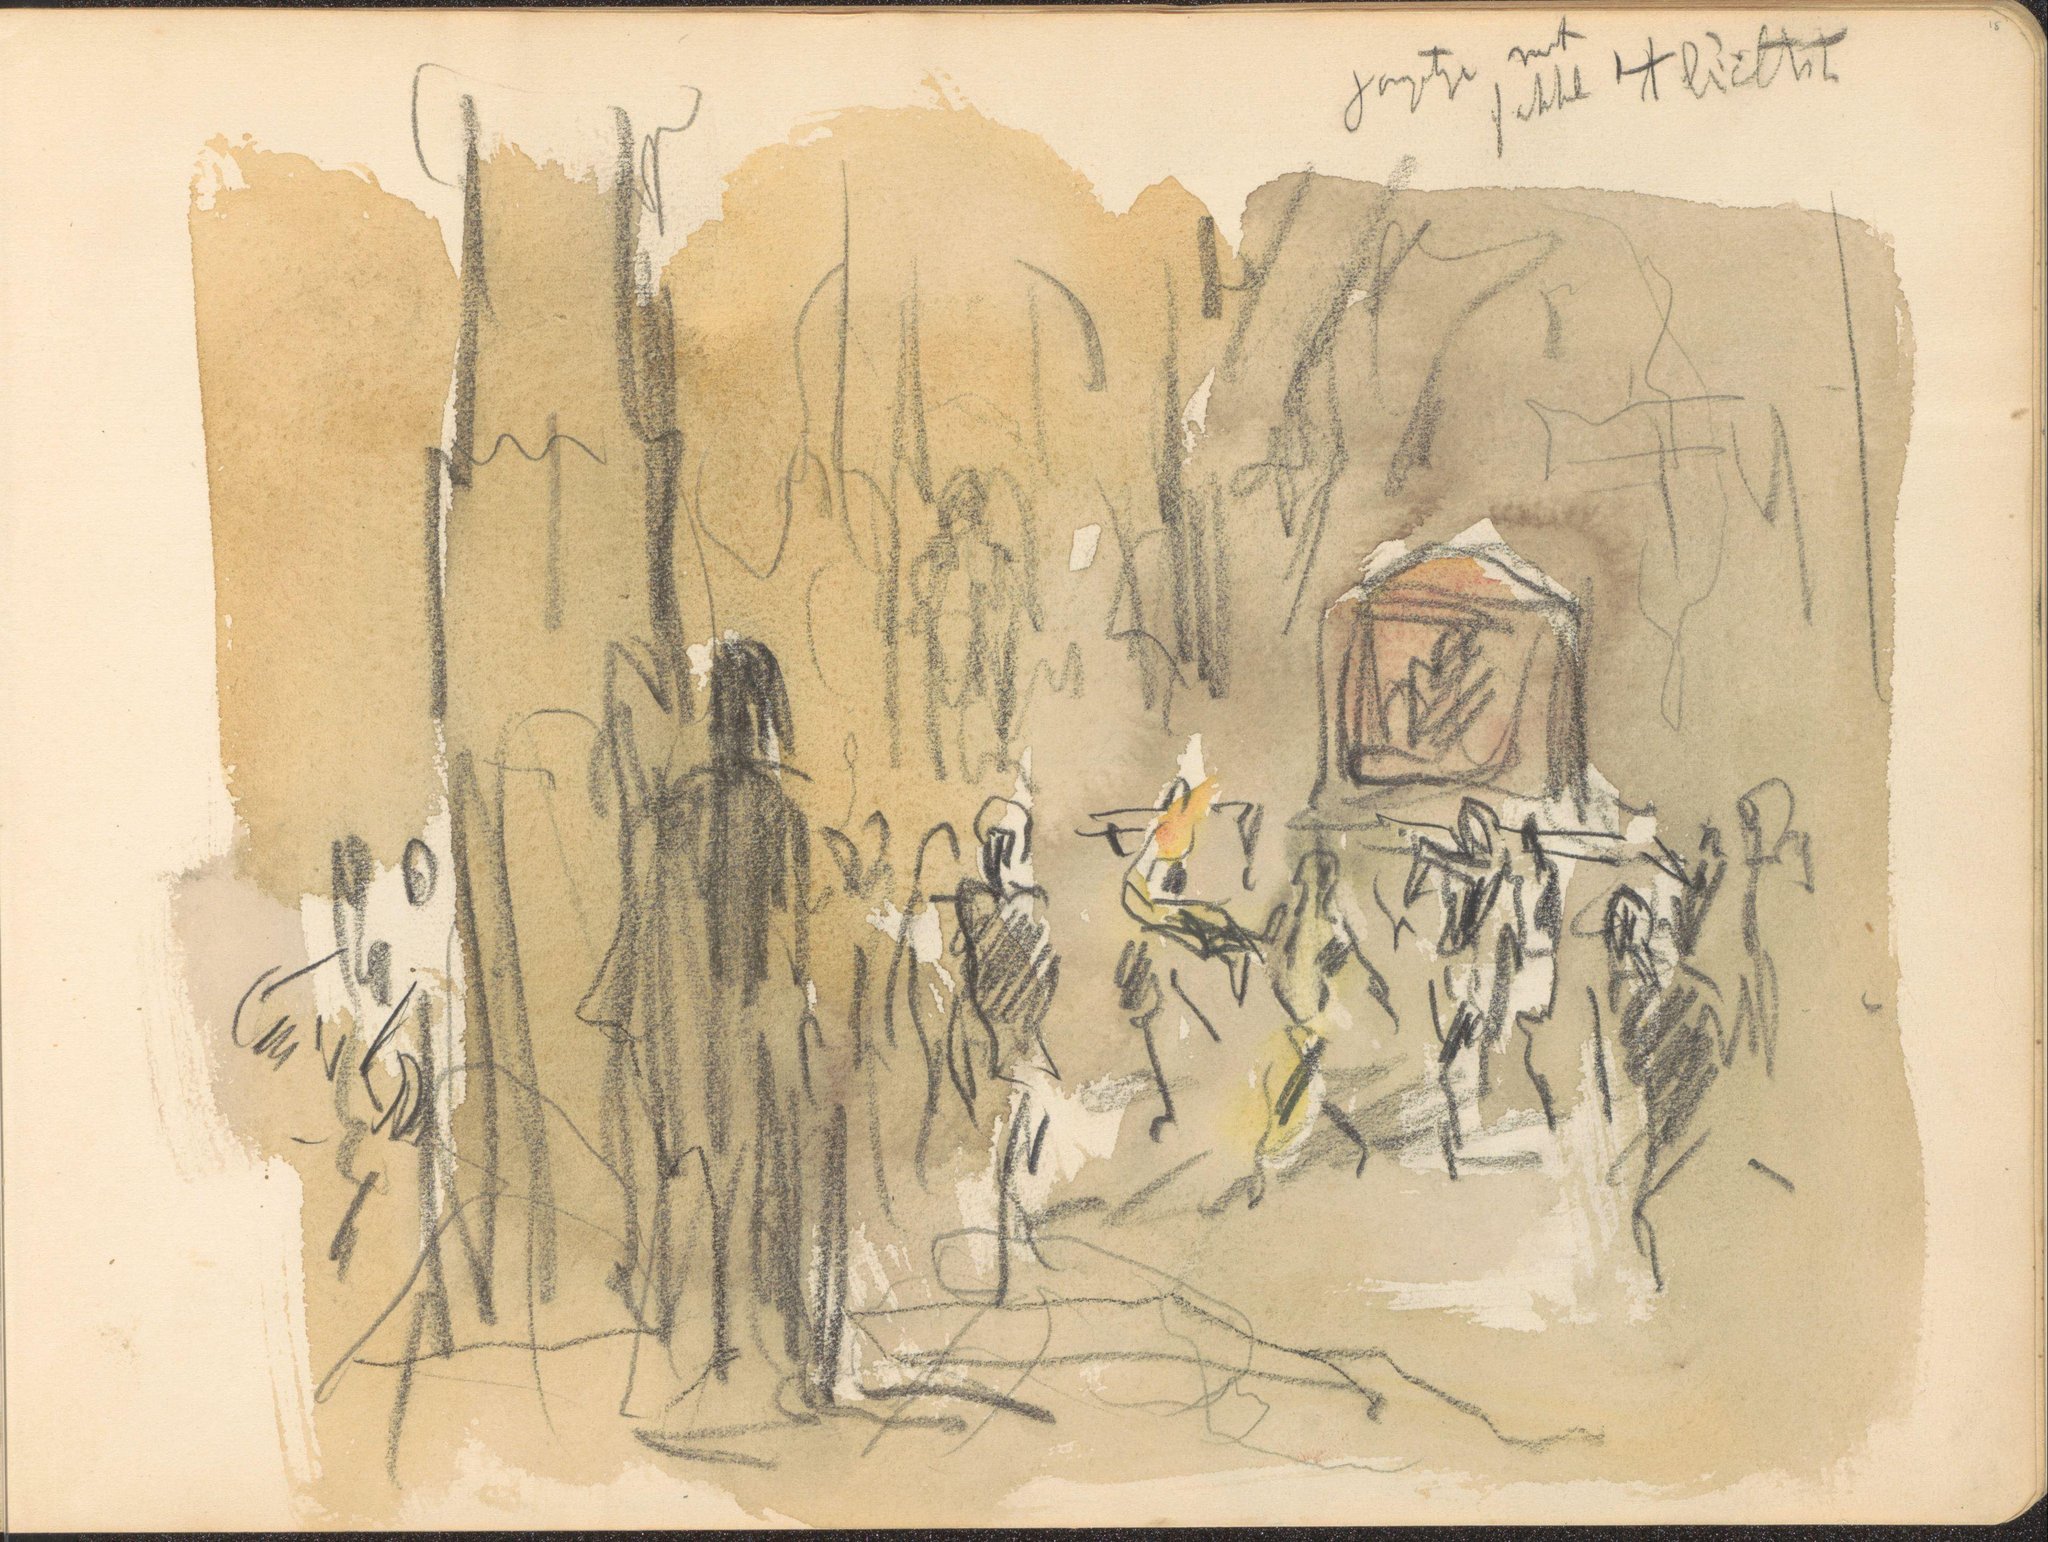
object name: sketchbook leaf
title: Jongen met een fakkel bij een houtvuur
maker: marius bauer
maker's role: draughtsman, print maker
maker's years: 1867-1932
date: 1924-1925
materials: chalk, paper, watercolor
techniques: brush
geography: sri lanka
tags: trees, torch, boy (child between toddler and youth), camp-fire; watch-fire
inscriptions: annotation: ‘jongetje met/ fakkel 't lichtst’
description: Rondom de jongen staan figuren op een open plek in een bosachtige omgeving, mogelijk een oerwoud. Pagina 15 uit een schetsboek met 20 bladen.